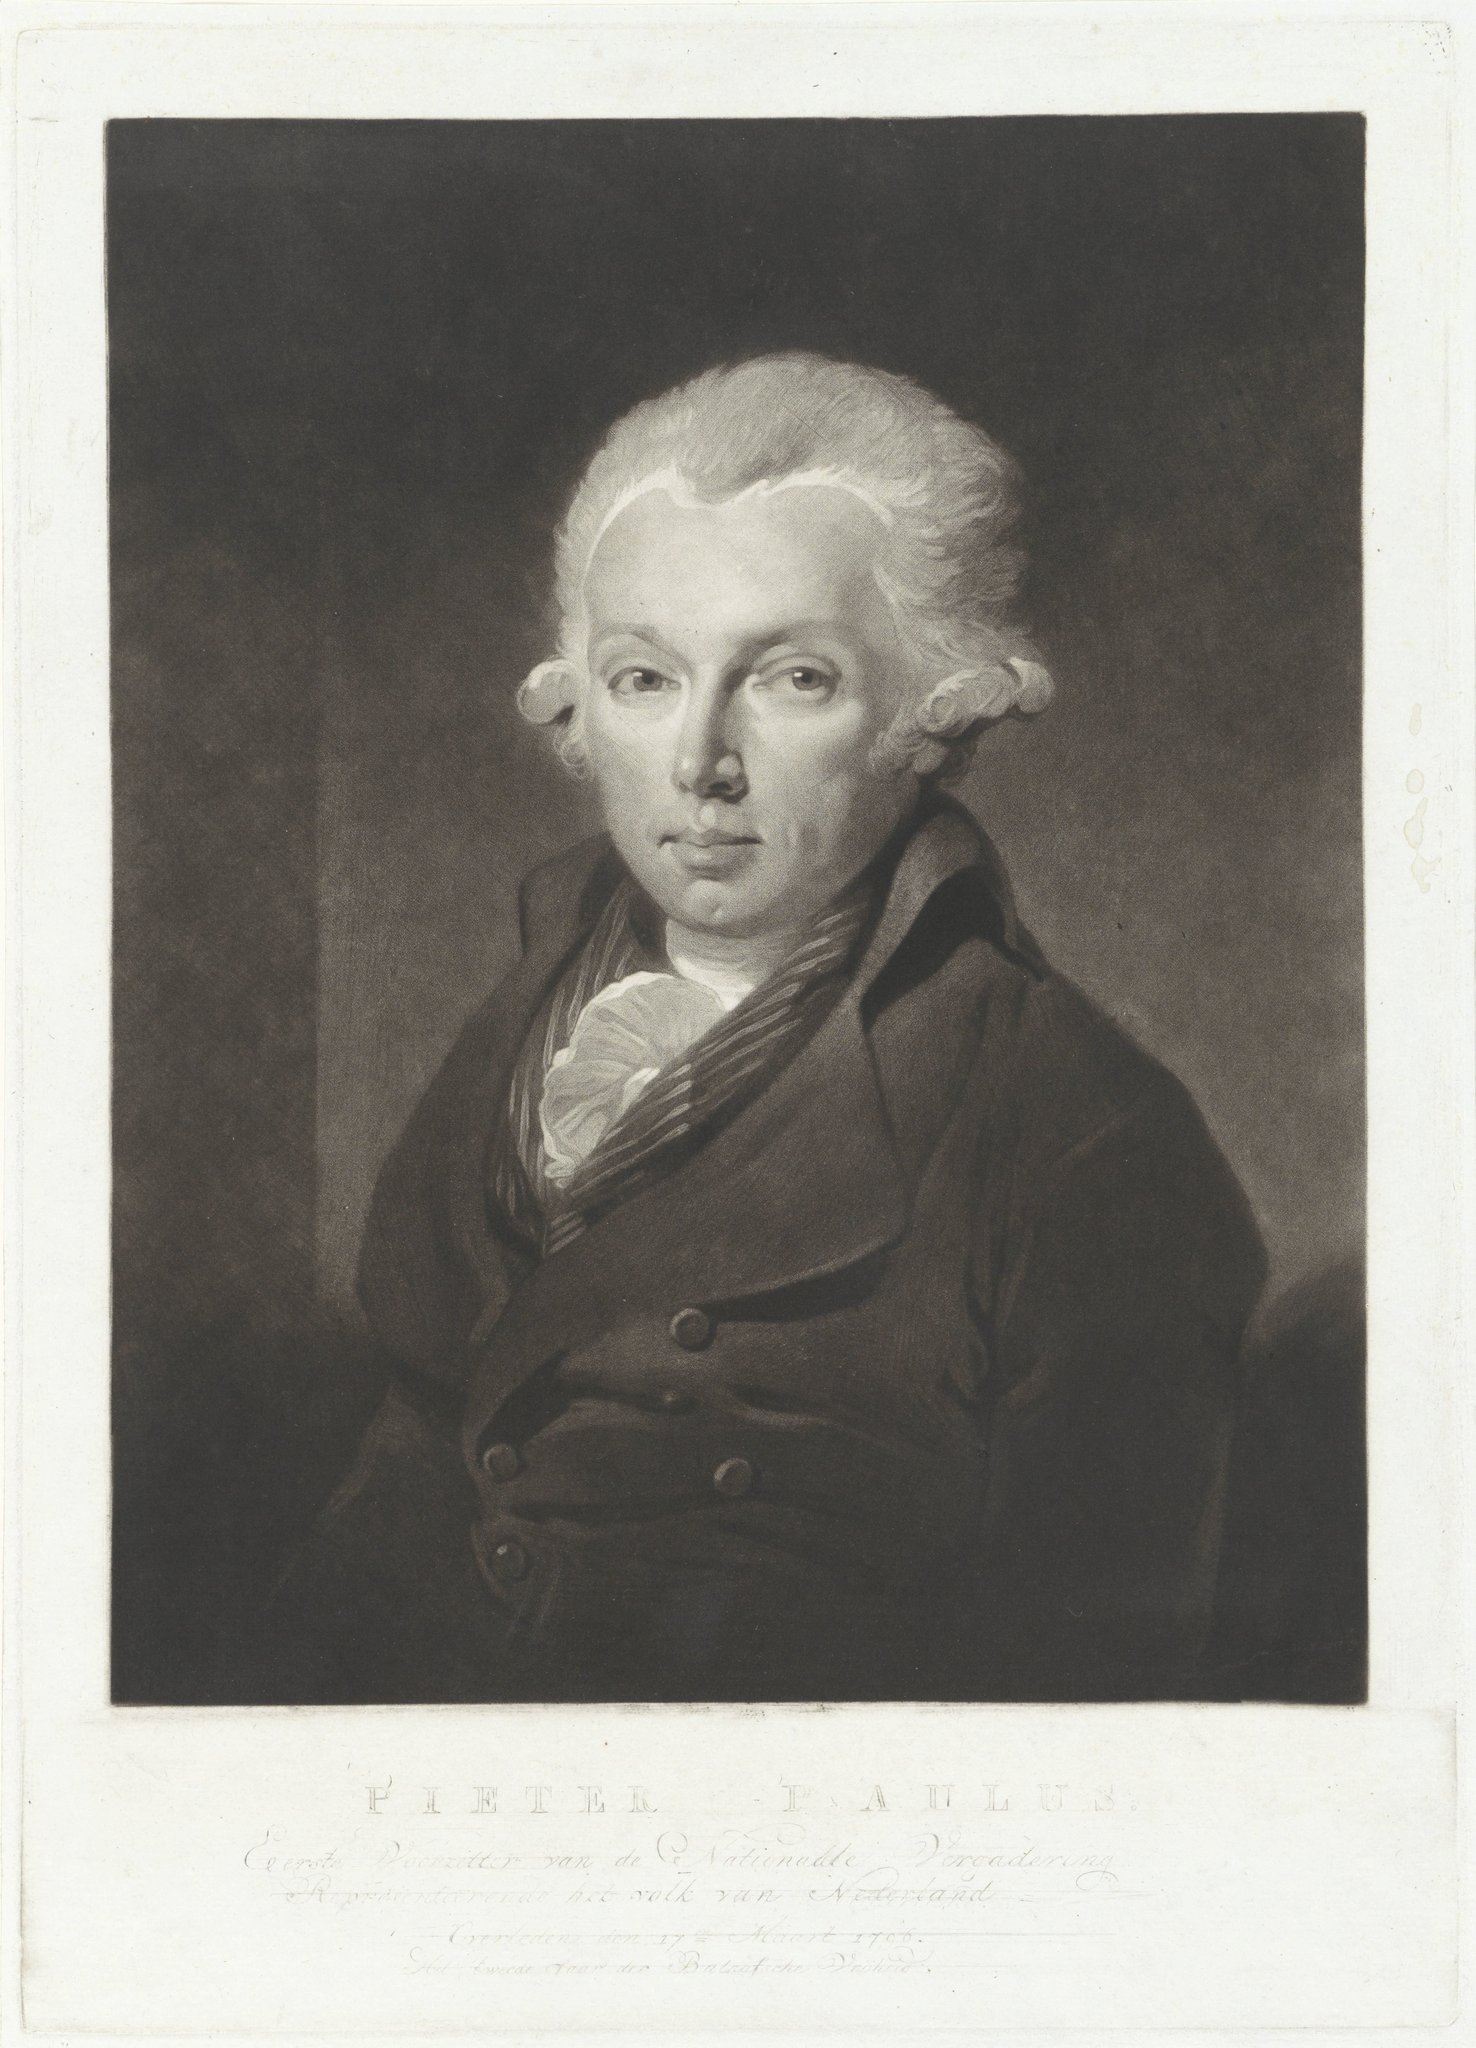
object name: print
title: Portret van Pieter Paulus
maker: charles howard hodges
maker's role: draughtsman, painter, print maker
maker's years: 1764-1837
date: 1795-1796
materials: paper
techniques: engraving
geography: the hague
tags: the hague, pieter paulus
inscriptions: date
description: Busteportret van de advocaat en politicus Pieter Paulus.